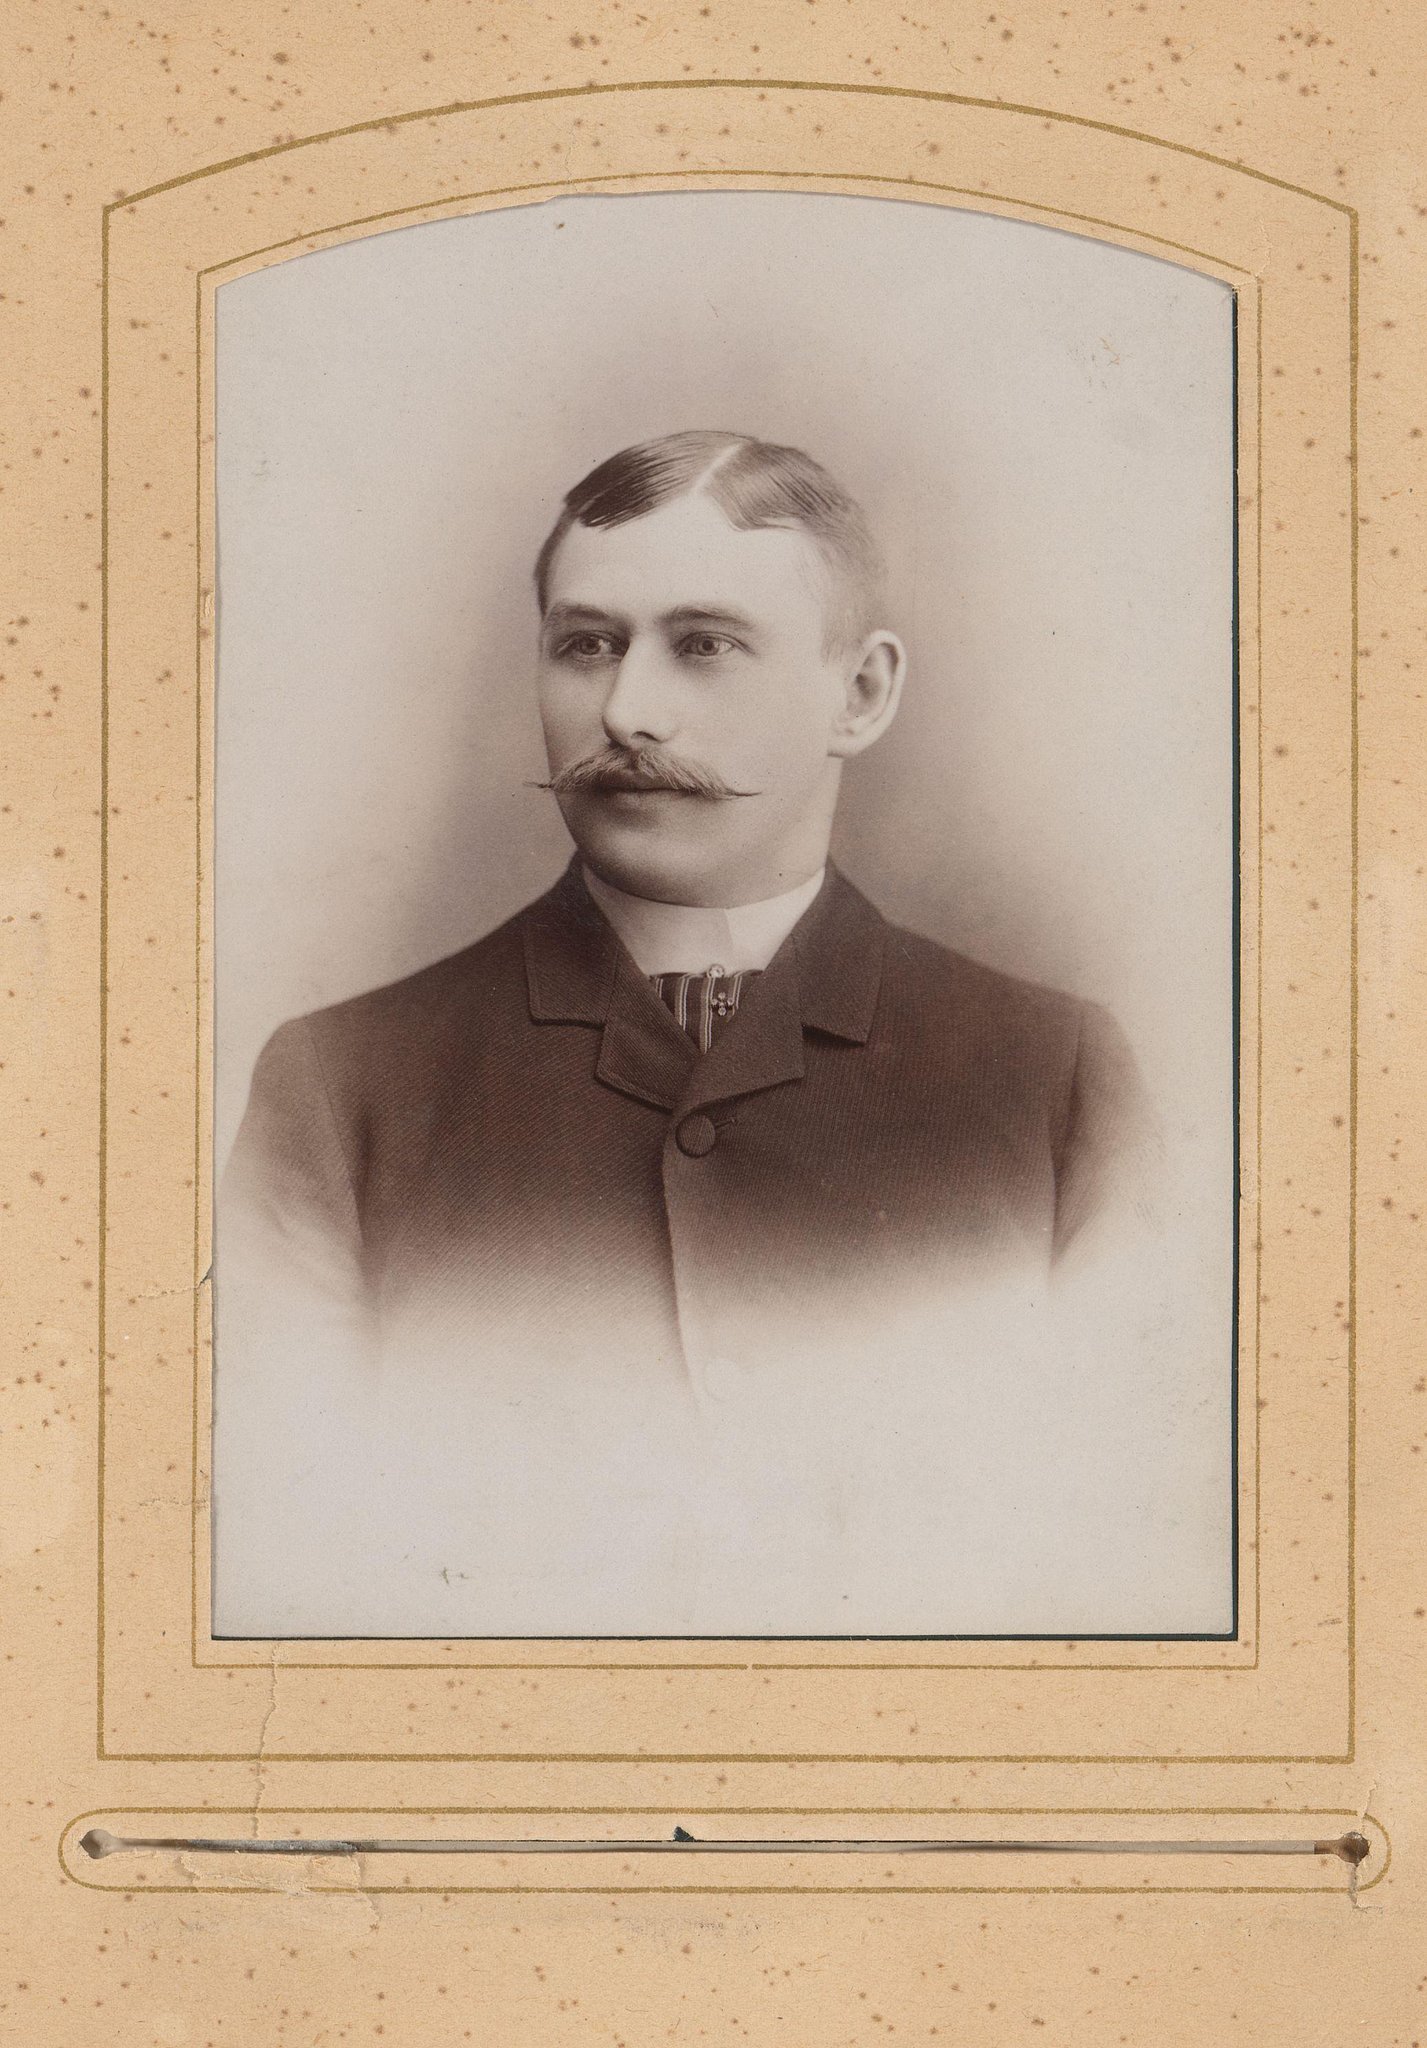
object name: photograph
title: Portret van een man met snor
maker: schneider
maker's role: fotograaf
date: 1860-1900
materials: cardboard, photographic support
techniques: albumen print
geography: chicago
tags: moustache, historical persons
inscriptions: inscription: ‘Schneider/ Photographer/ 2135/ Archer Ave/ chicago./ negatives preserved for future orders.’